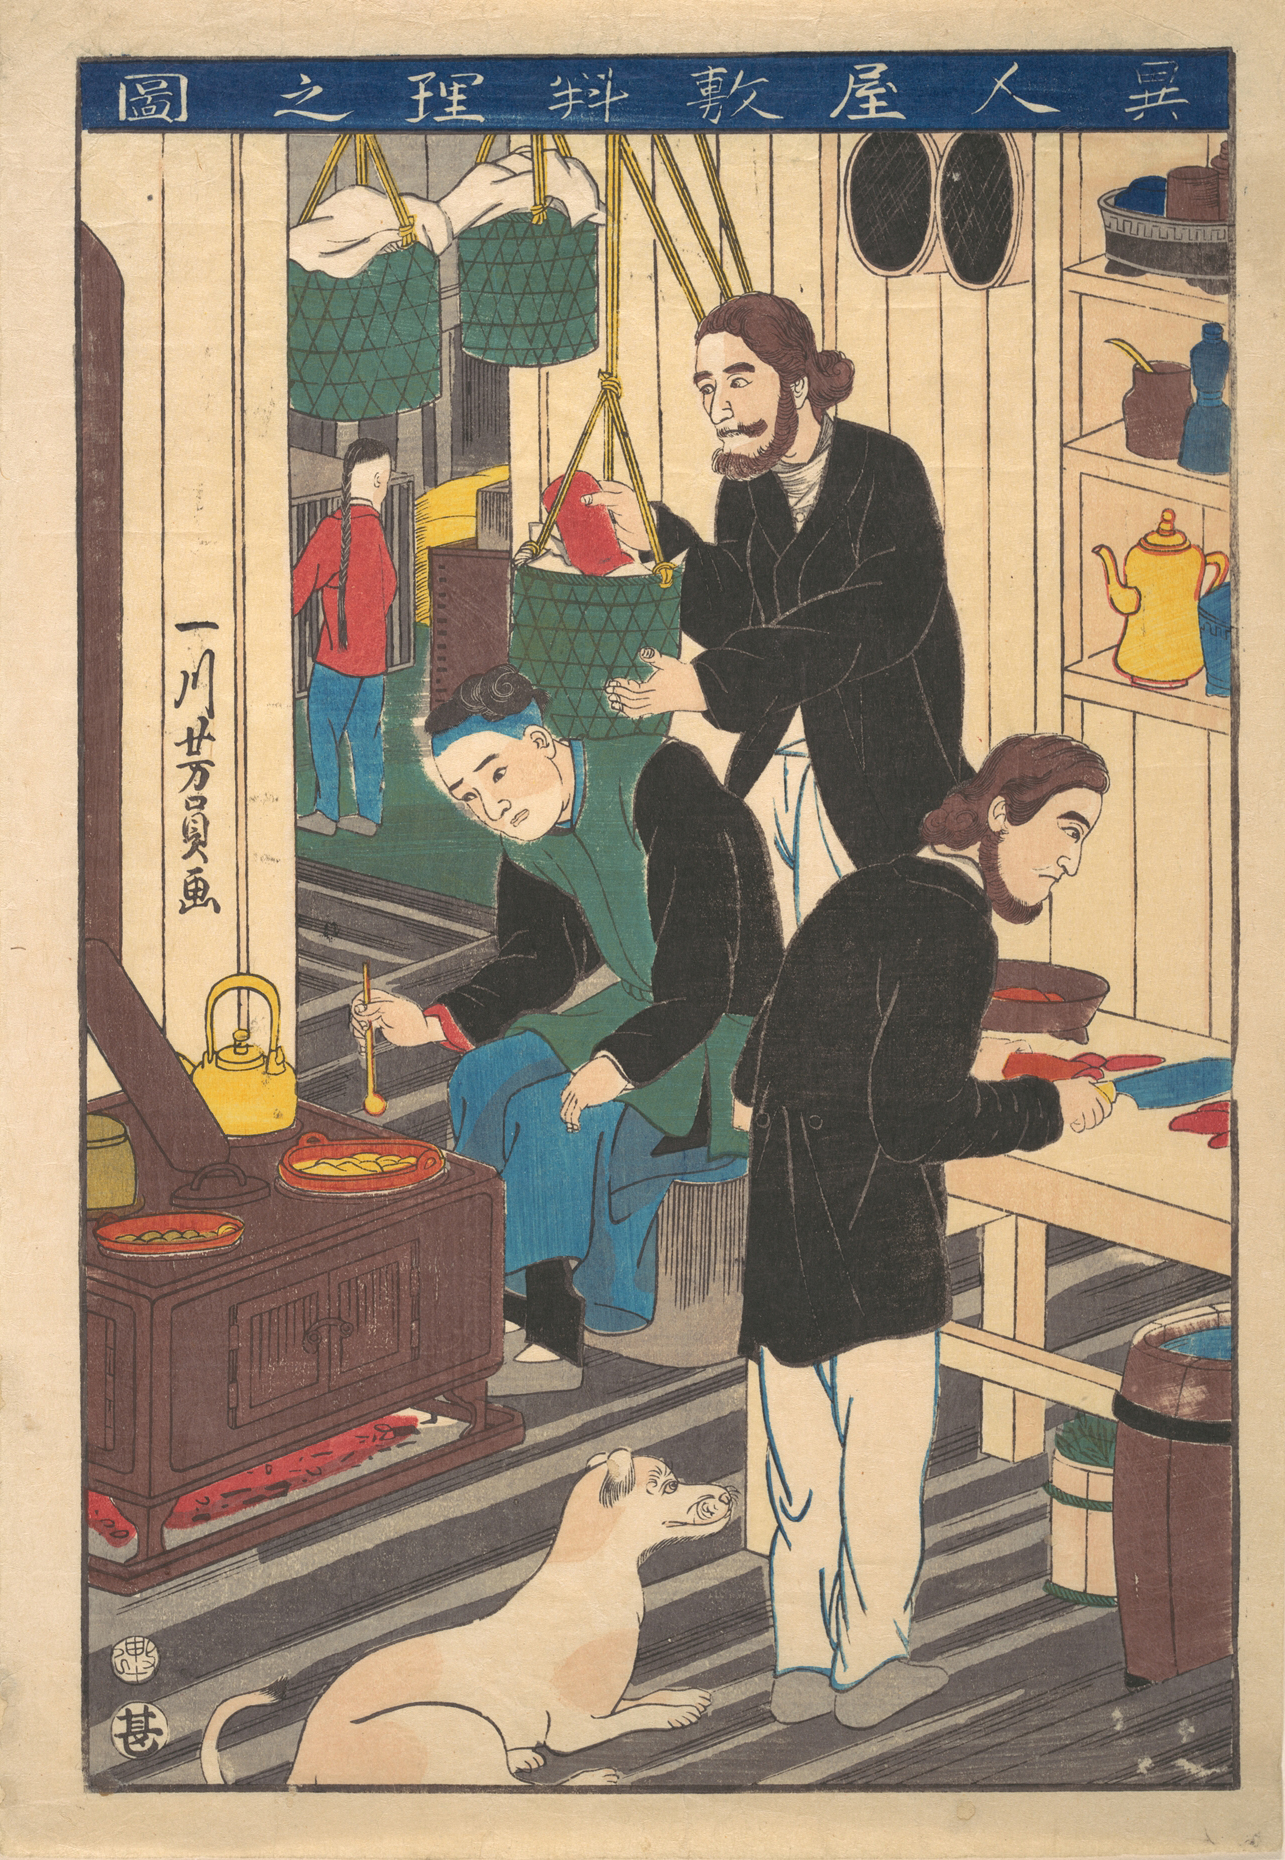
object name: print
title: Inside a Foreign Restaurant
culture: japanese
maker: utagawa yoshikazu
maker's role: artist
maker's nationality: japanese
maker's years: 1845-1870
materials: ink, paper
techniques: woodblock print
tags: food,restaurants,kitchens,men,dogs,cooking